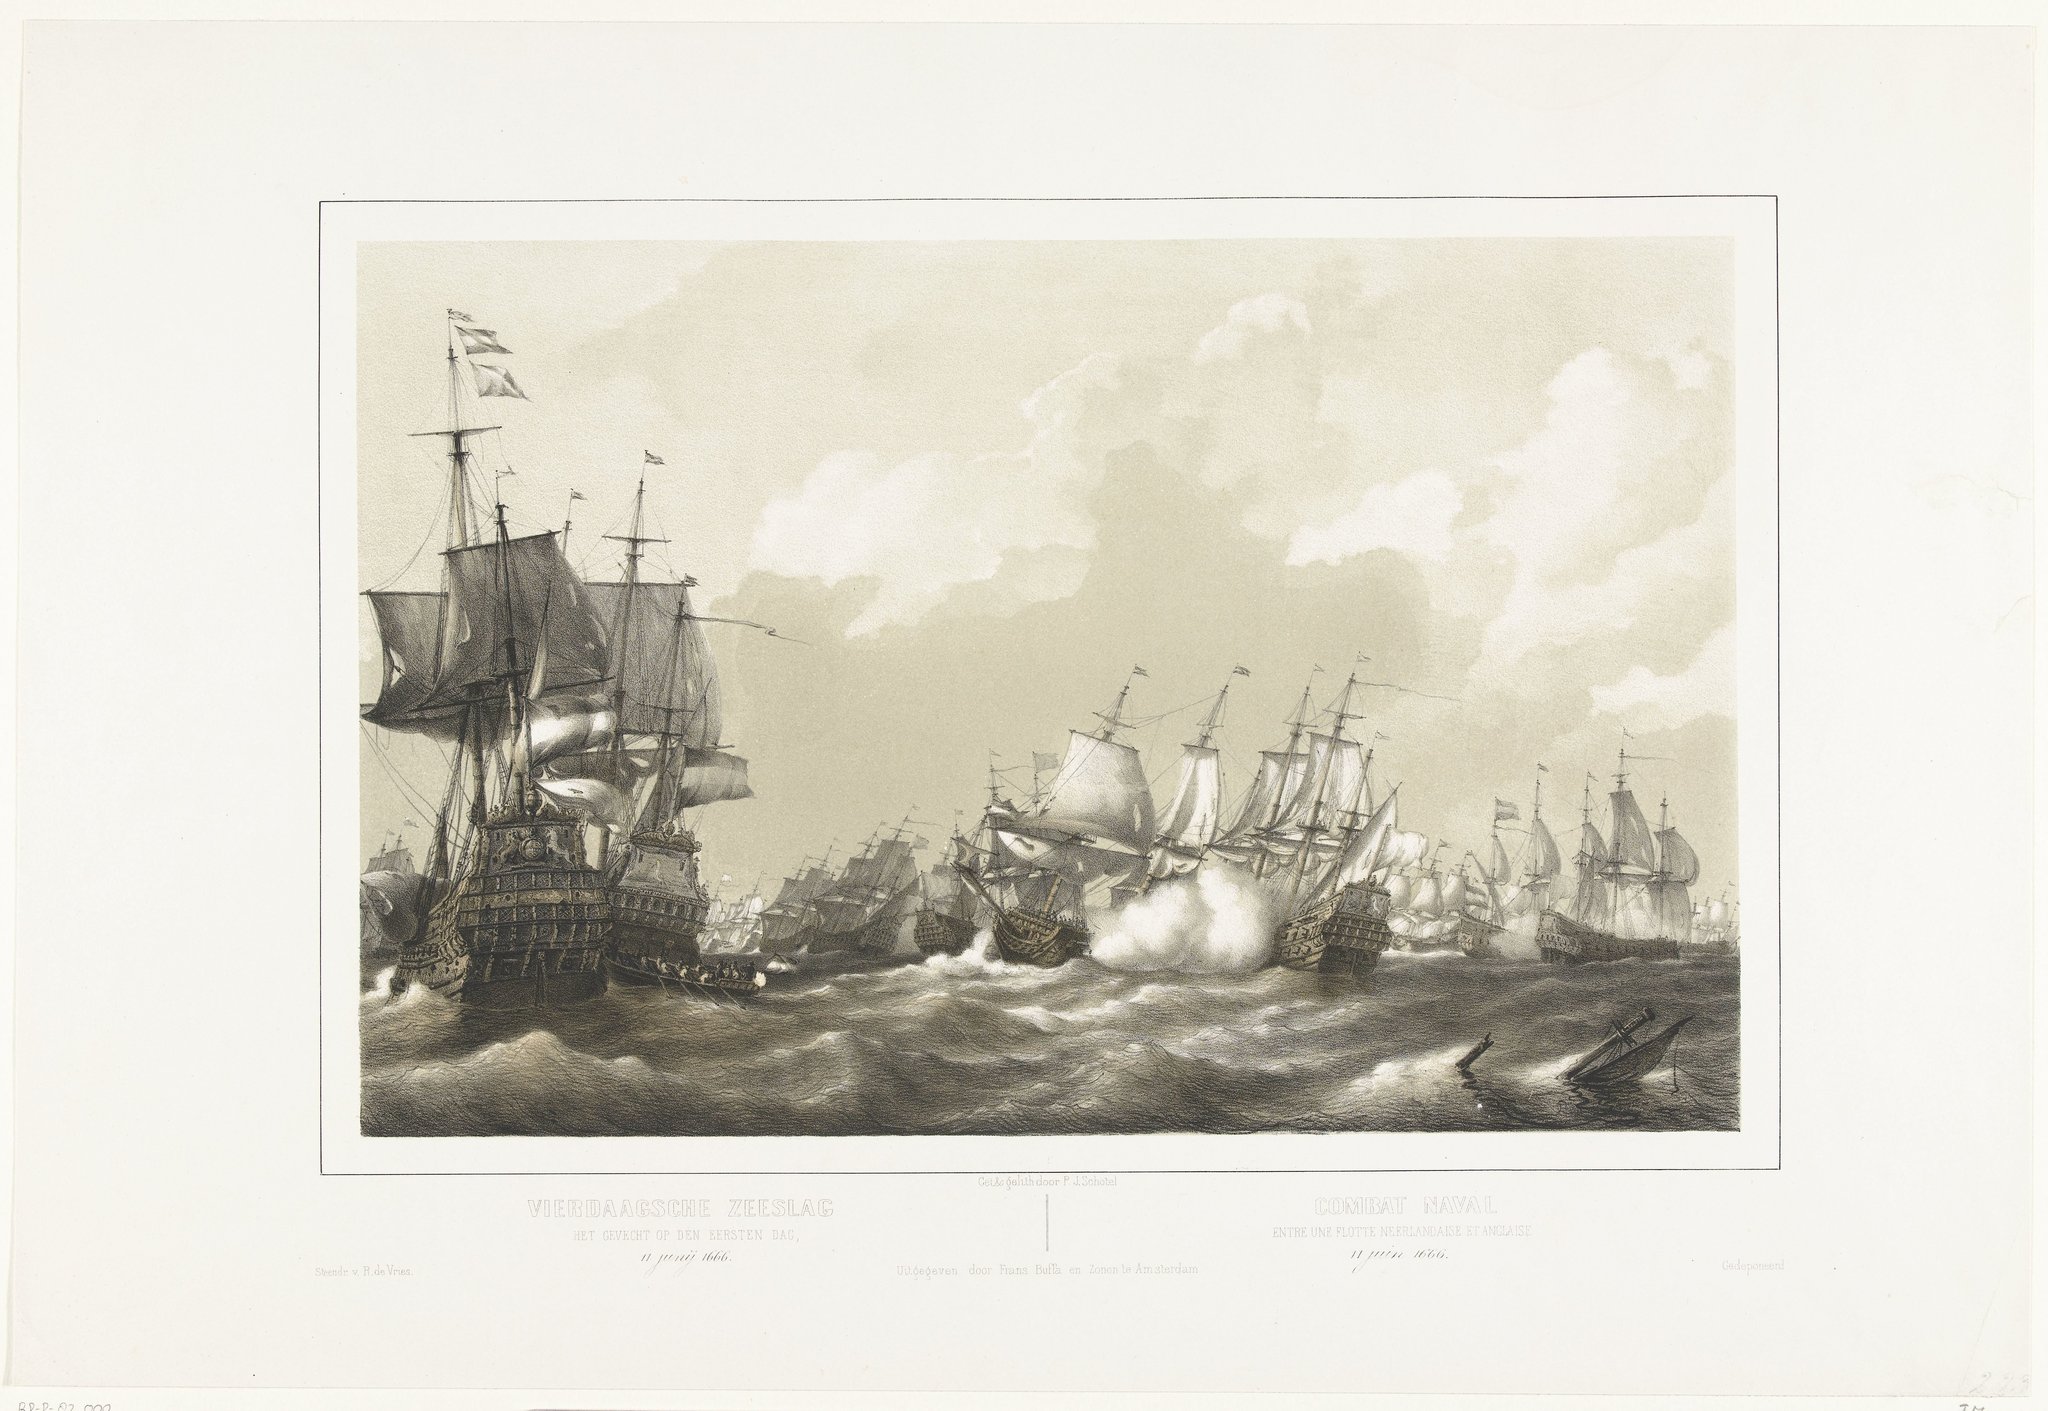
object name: print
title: De Vierdaagse Zeeslag, 1666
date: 1848-1855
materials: paper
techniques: lithograph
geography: amsterdam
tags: flushing, michiel adriaenszoon de ruyter, battle (+ naval force)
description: Uitgegeven in: P.J. Schotel, Heldendaden der Nederlanders ter zee, van de vroegste tijden tot op heden, naar aanleiding van de: Geschiedenis van het Nederlandsche zeewezen, Frans Buffa en Zonen, Amsterdam 1850-1855, pl. 25. Zonder de uitvoerige beschrijving vermeld bij Muller.